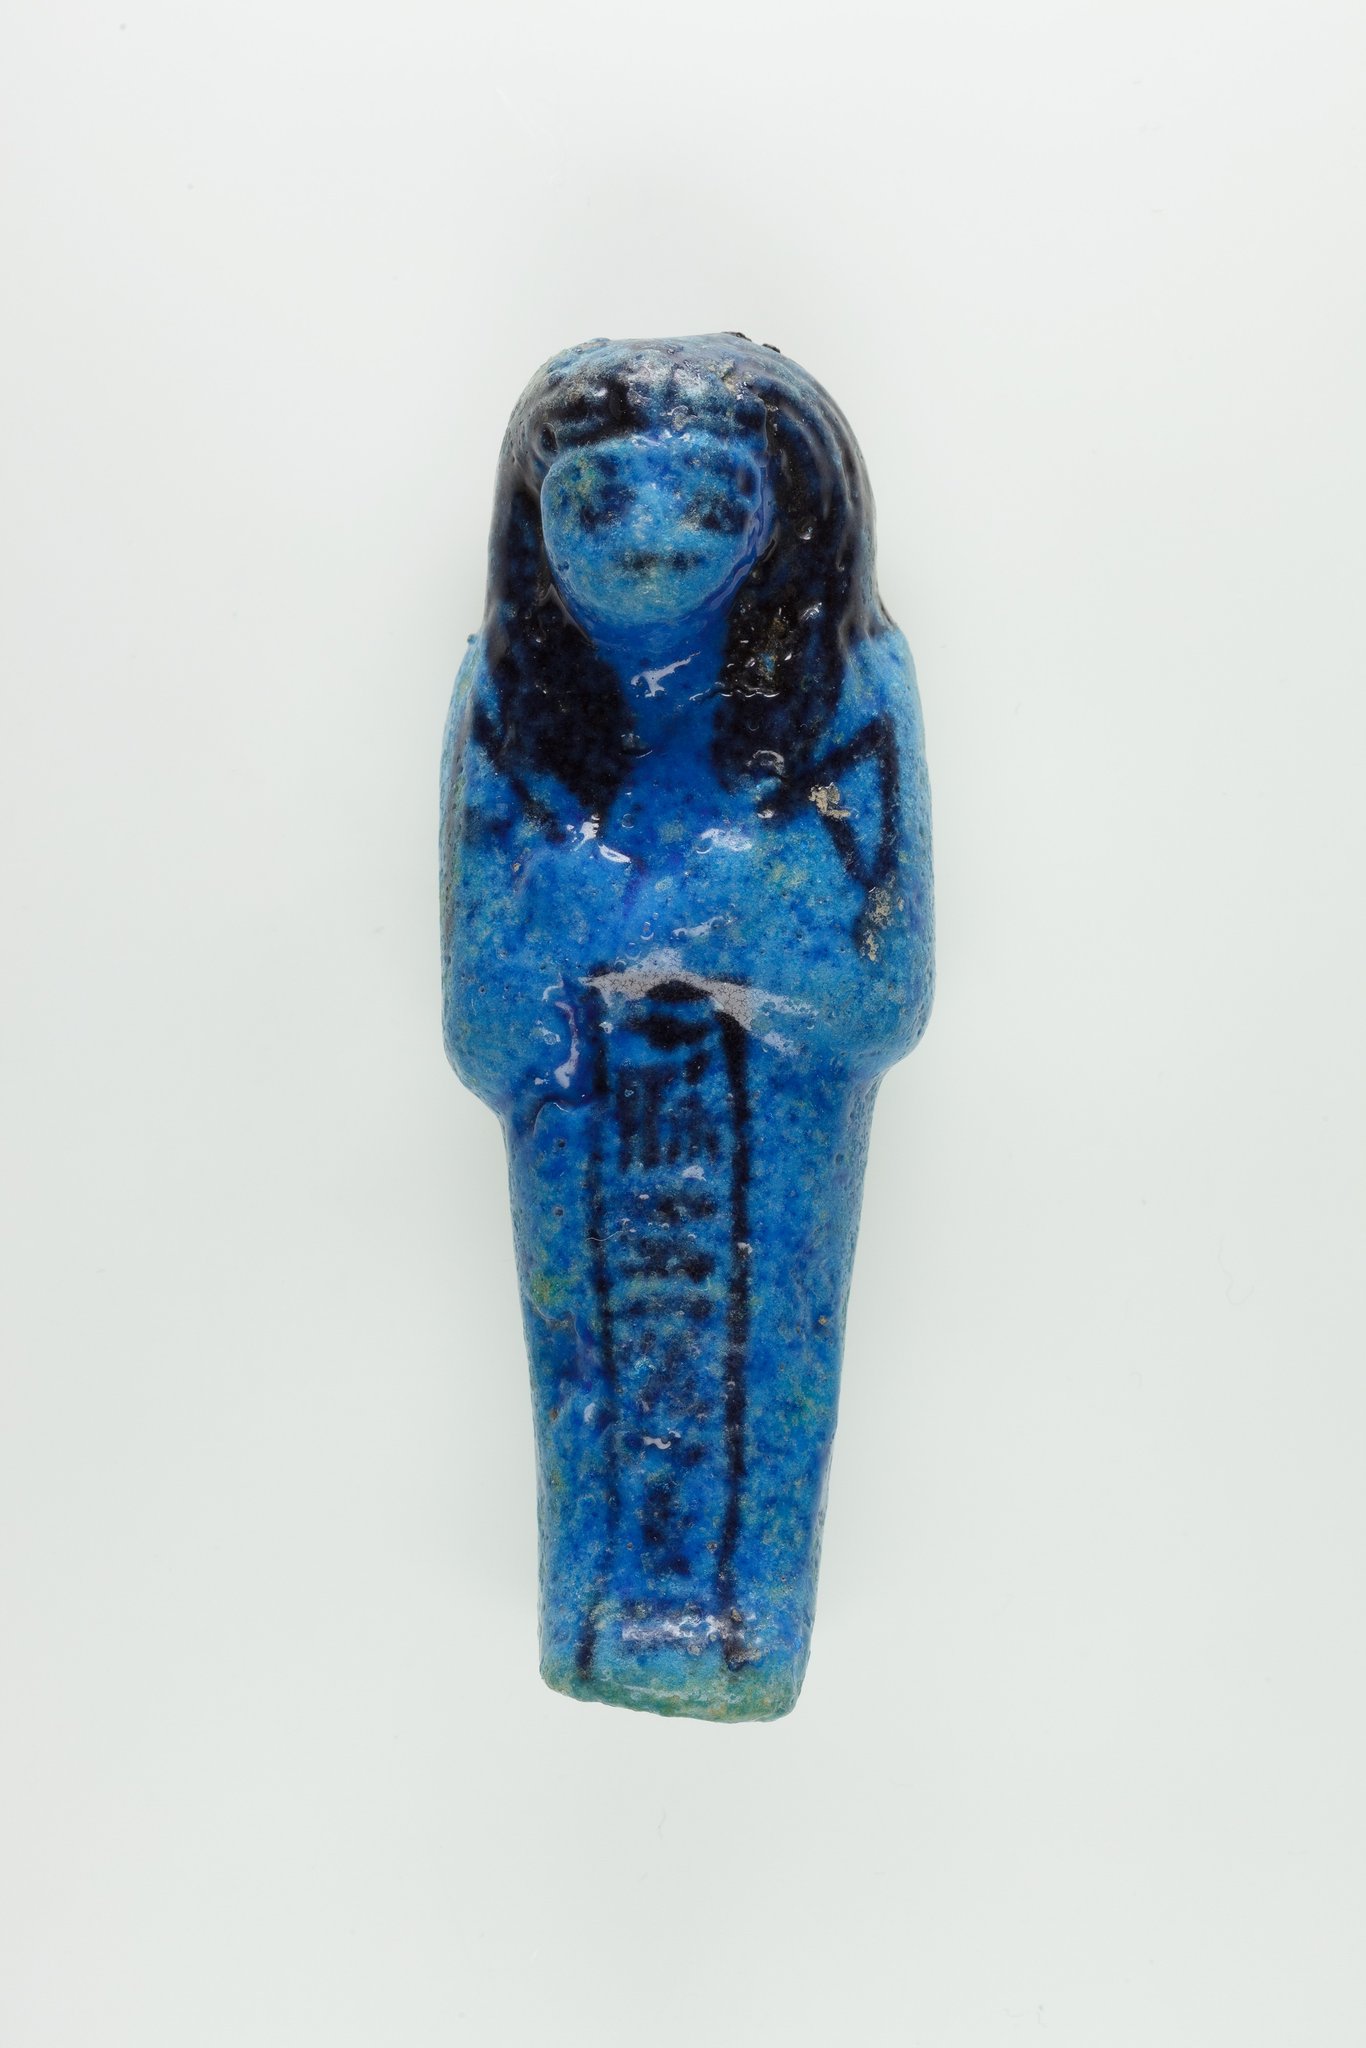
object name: shabti, worker, nauny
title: Worker Shabti of Nauny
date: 1050 BCE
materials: faience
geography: egypt